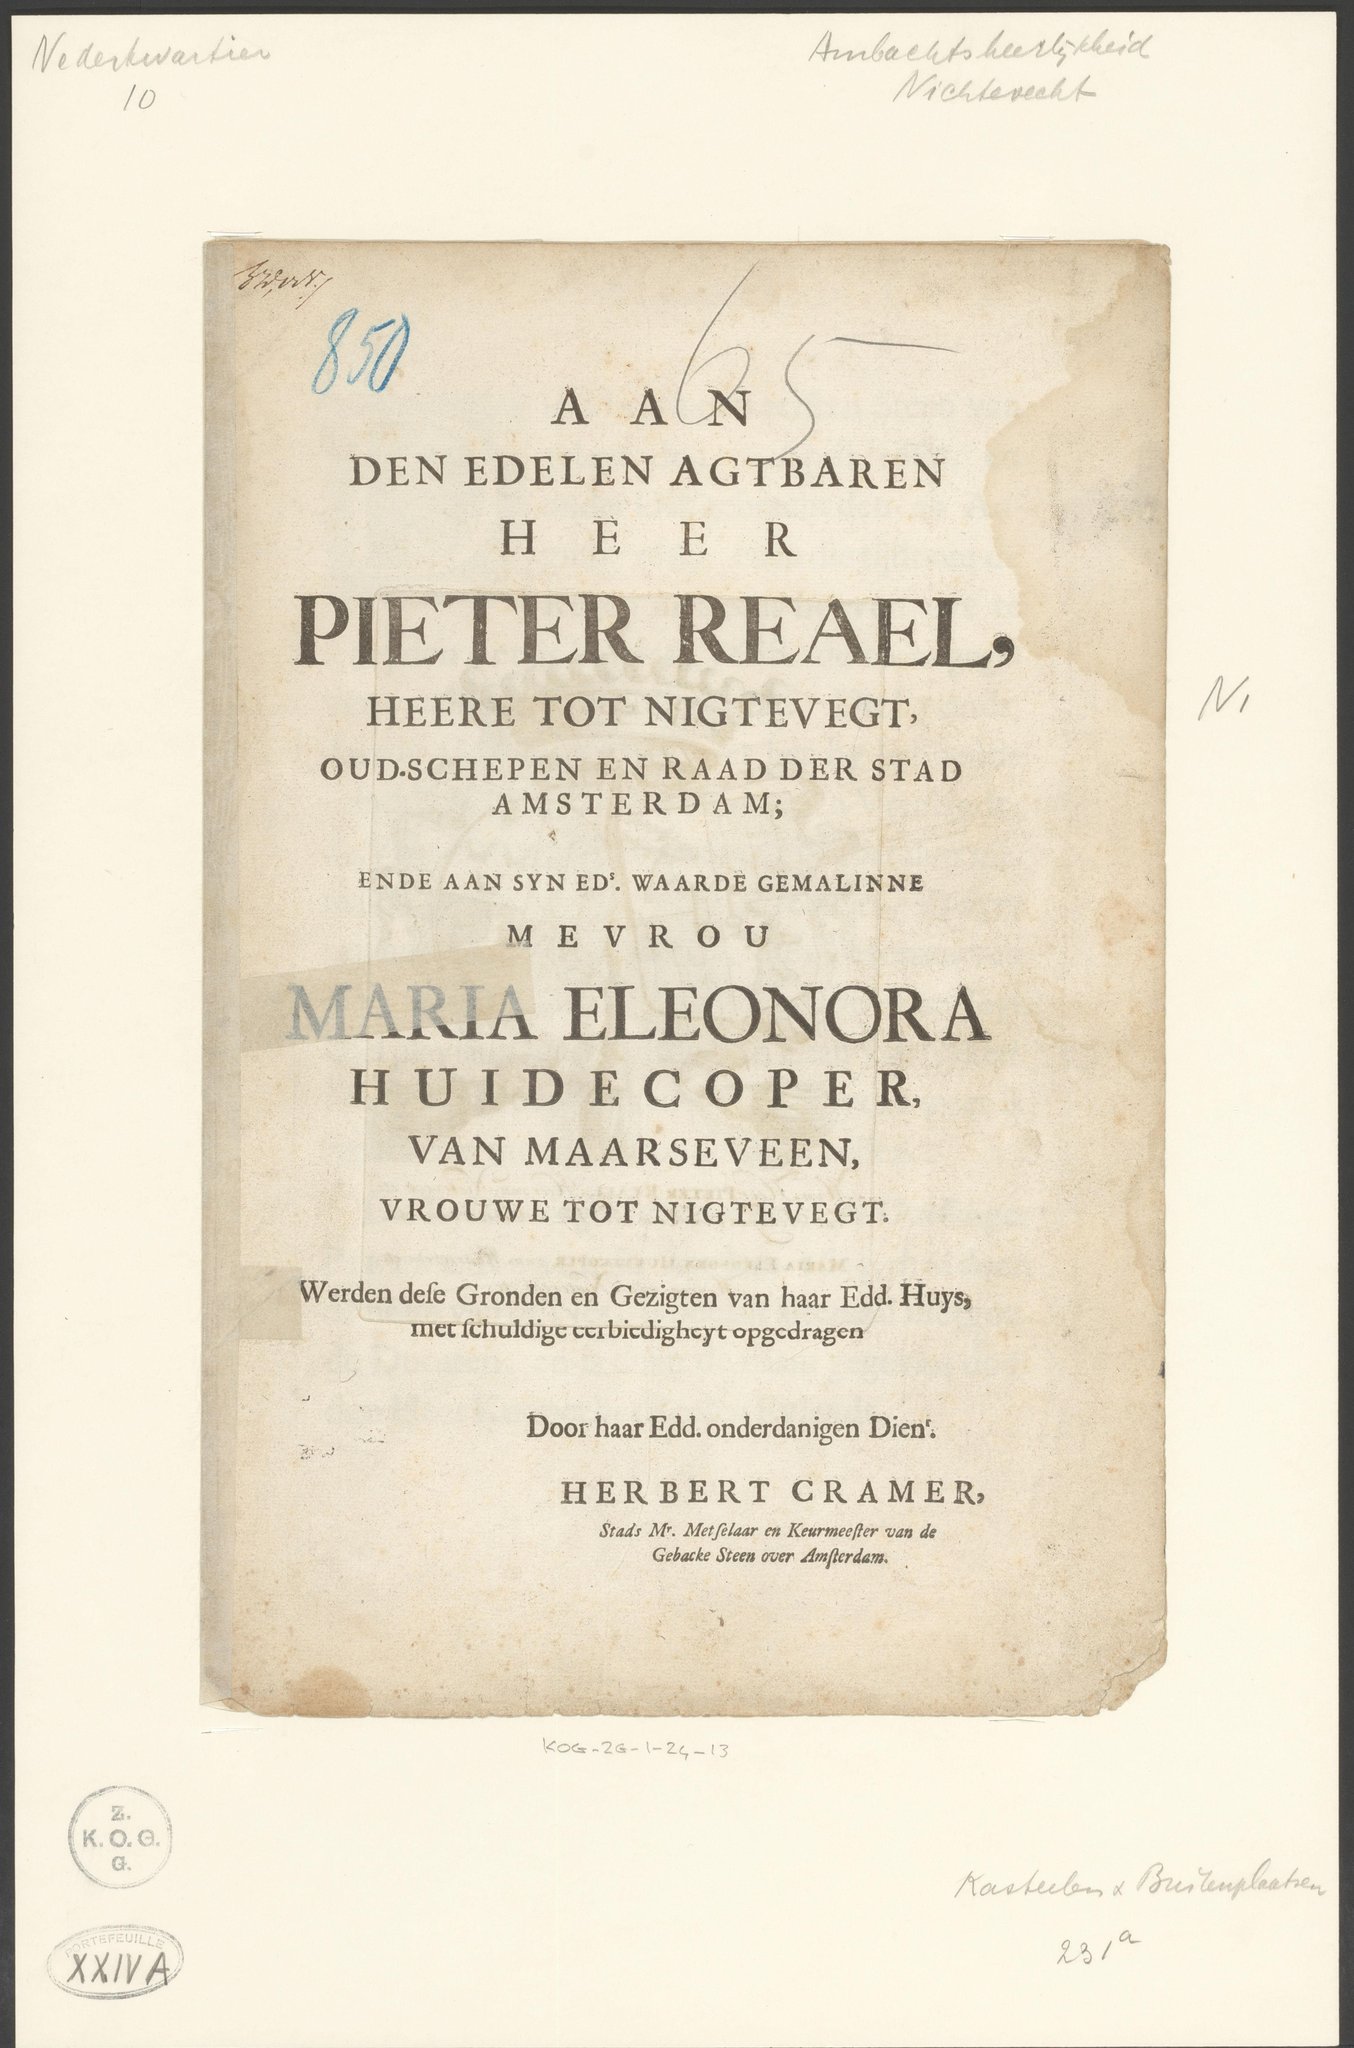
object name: text sheet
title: Aan den edelen agtbaren heer Pieter Reael (...)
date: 1687-1693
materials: paper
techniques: engraving, letterpress printing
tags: armorial bearing, heraldry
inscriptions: stamp, collector's mark: Lugt 1641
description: Huis De Nes of Realeneiland te Vreeland. Het voor de Amsterdamse familie Reaal in 1687 gebouwde buitenhuis lag op een eiland in de Vecht. Onderwerpsrubrieken binnen de Atlas Zeden en Gewoonten: Zeden en Gewoonten in Engeren Zin, De Woning. Kastelen en buitenplaatsen. Utrecht (vervolg.).